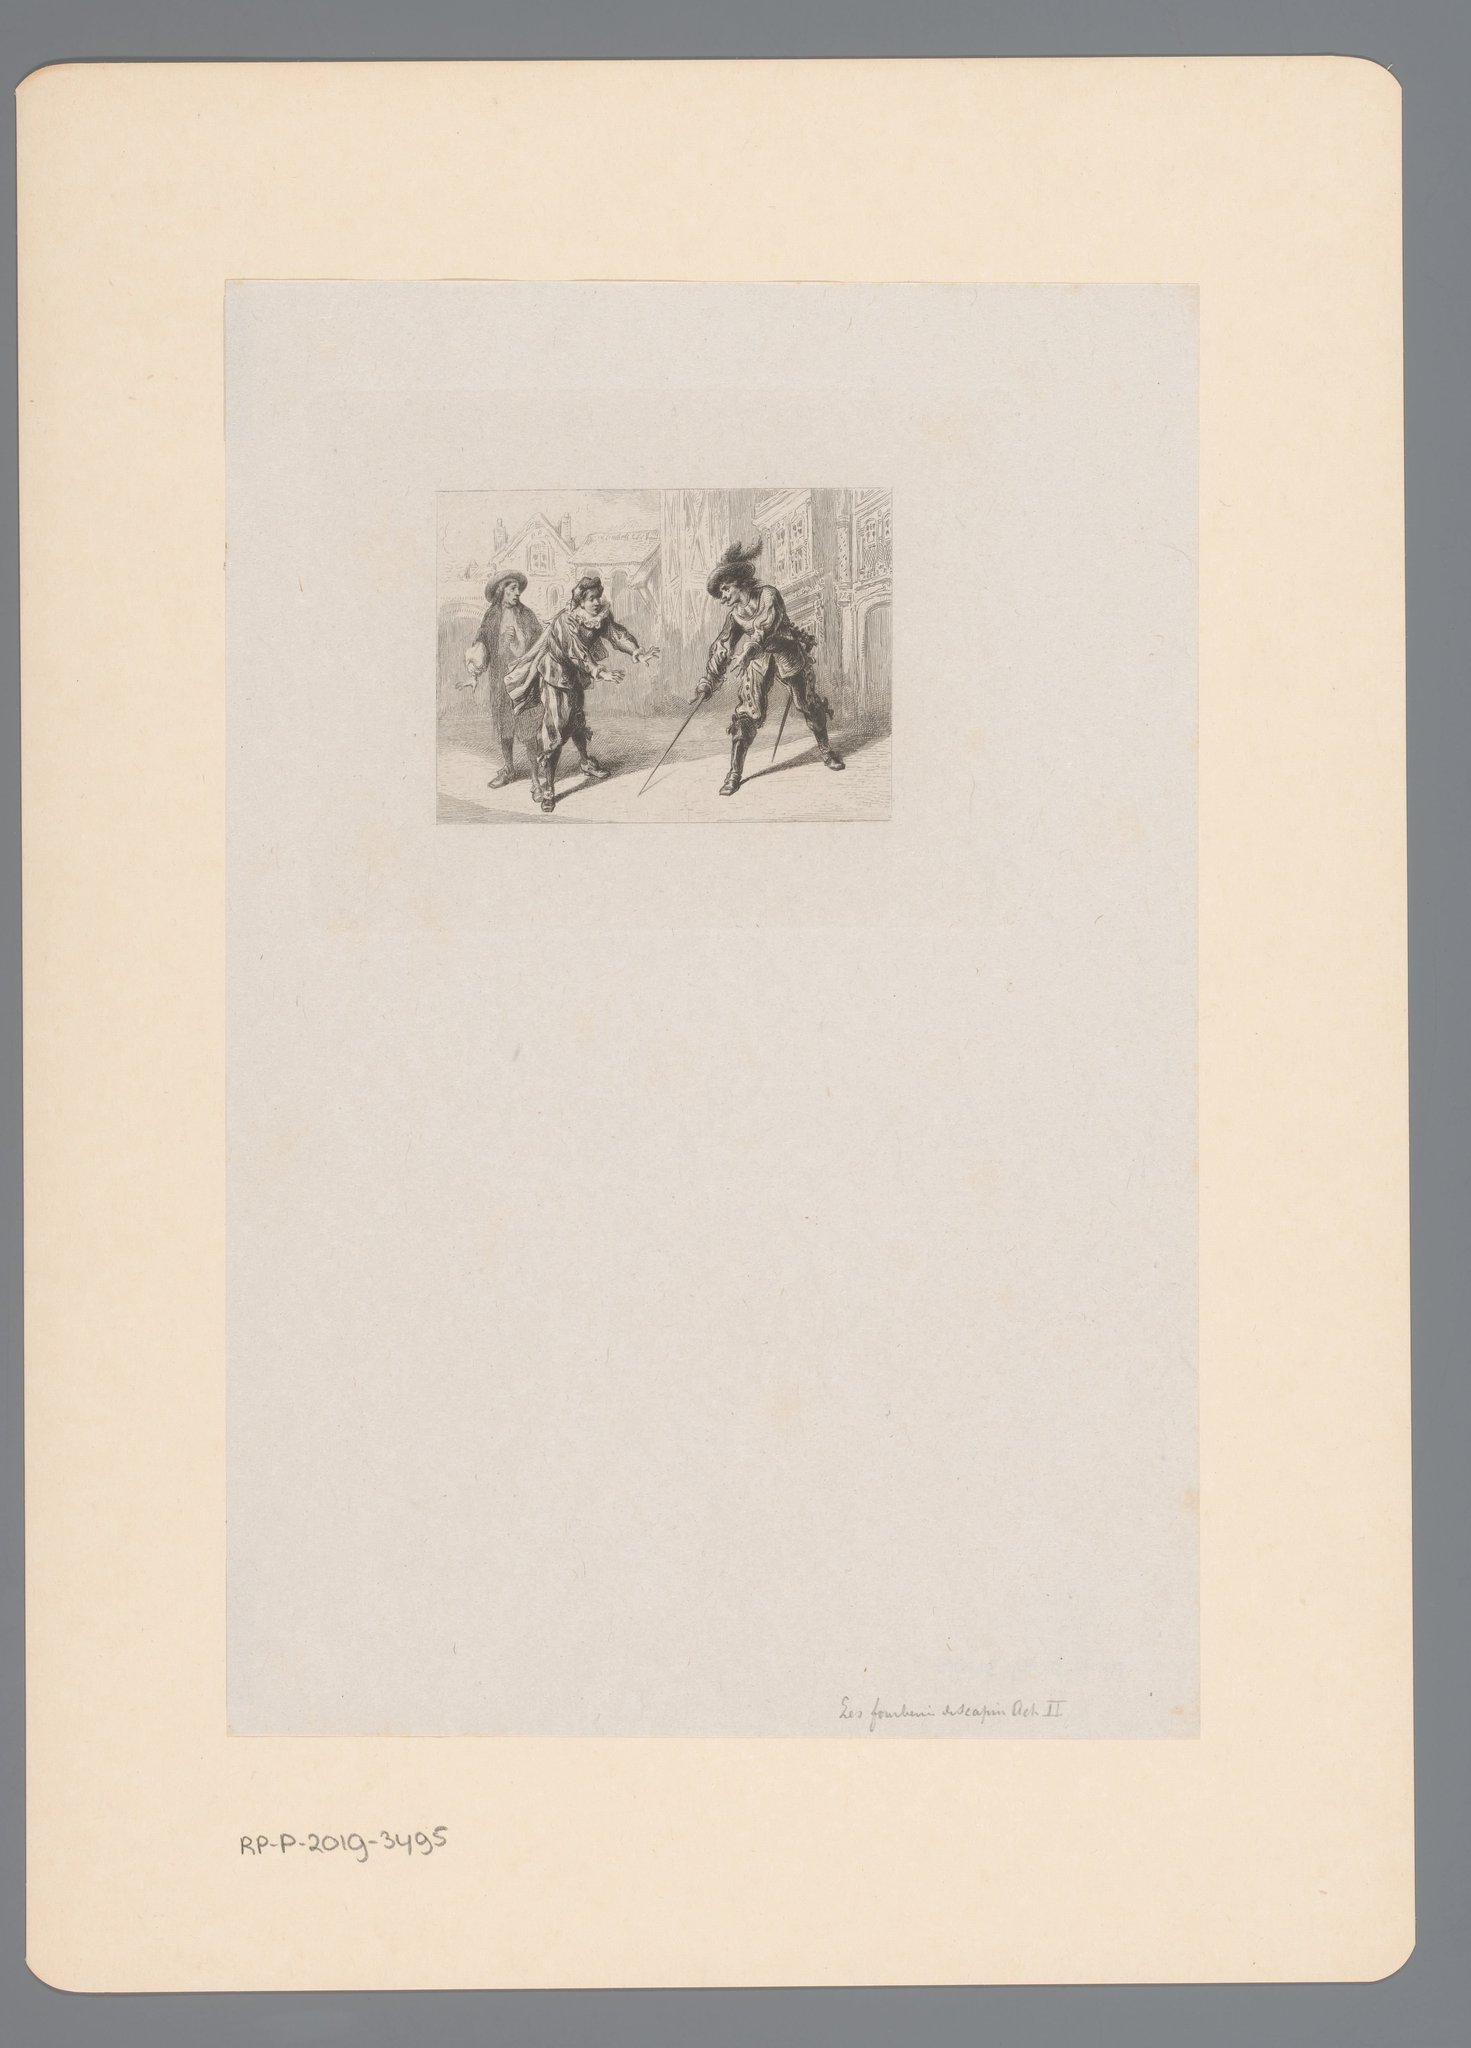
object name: print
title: Molière Théatre Choisi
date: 1878-1879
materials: paper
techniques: drypoint, etching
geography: tours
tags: theatre, theatrical performance, hacking and thrusting weapons, duelling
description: Akte II, scène III uit "Les Fourberies de Scapin" van Molière. Scapin probeert Léandre ervan te weerhouden aan te vallen.